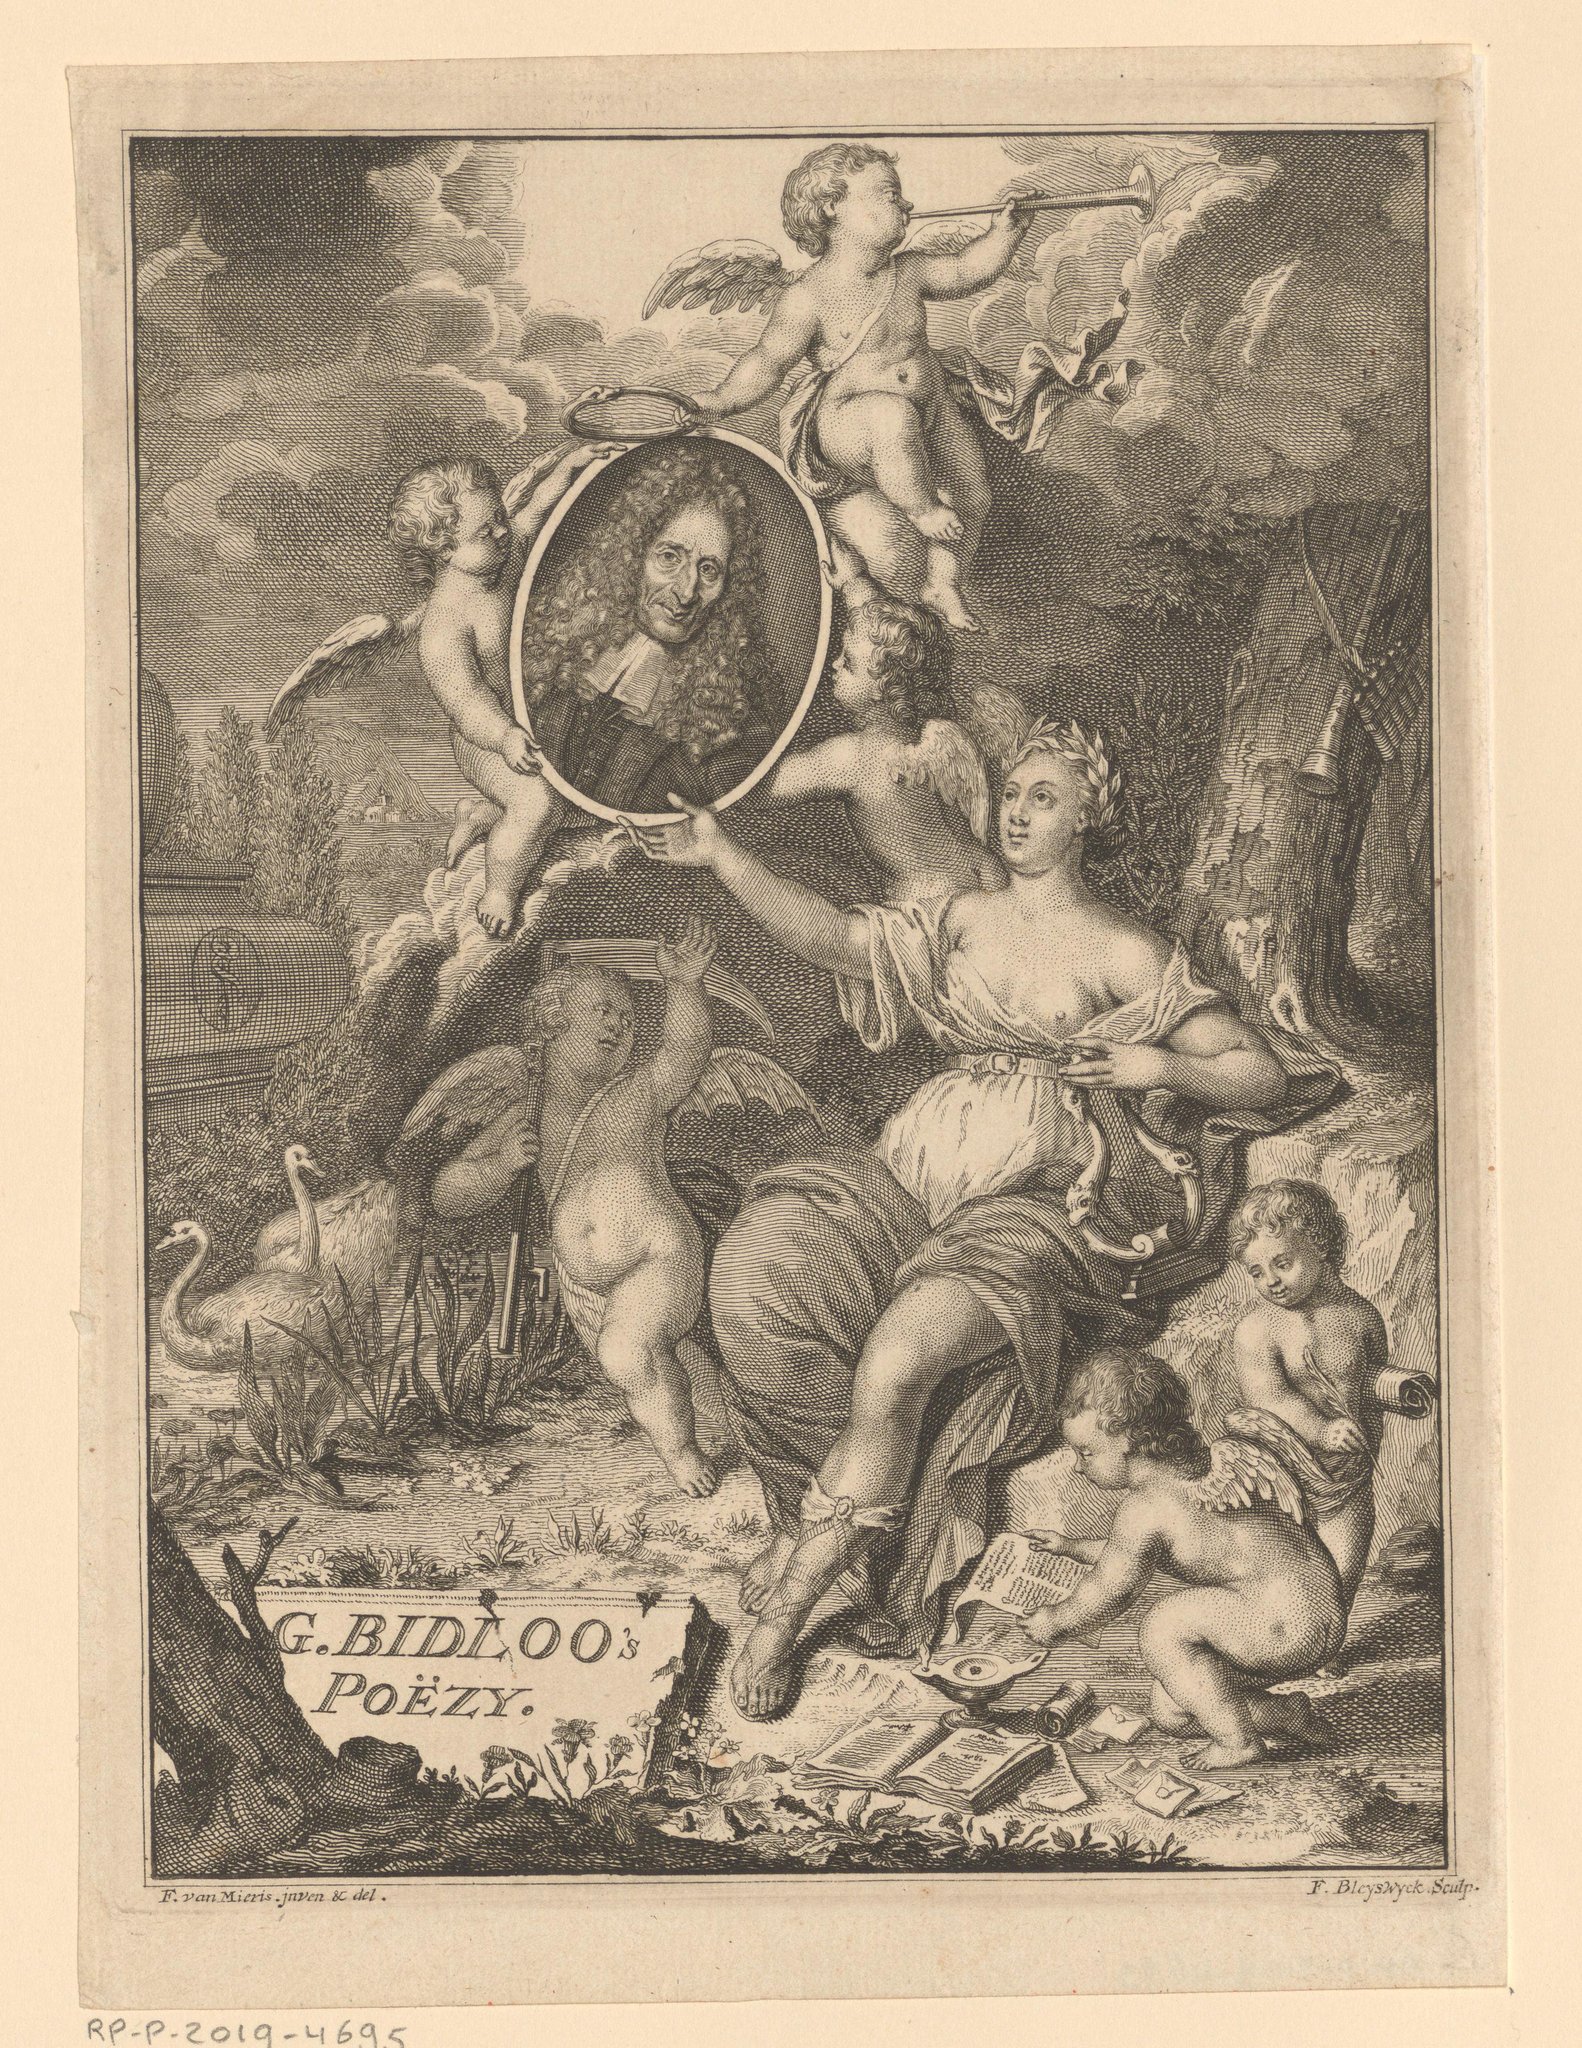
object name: print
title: Titelpagina voor: Govard Bidloo, Mengel poëzy, 1719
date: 1719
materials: paper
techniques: etching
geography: leiden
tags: leiden, govard bidloo, historical persons, writer, poet, author, cupids: 'amores', 'amoretti', 'putti'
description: Titelpagina voor: Bidloo, Govard. Mengel poëzy. Leiden: Johan Arnold Langerak, 1719.